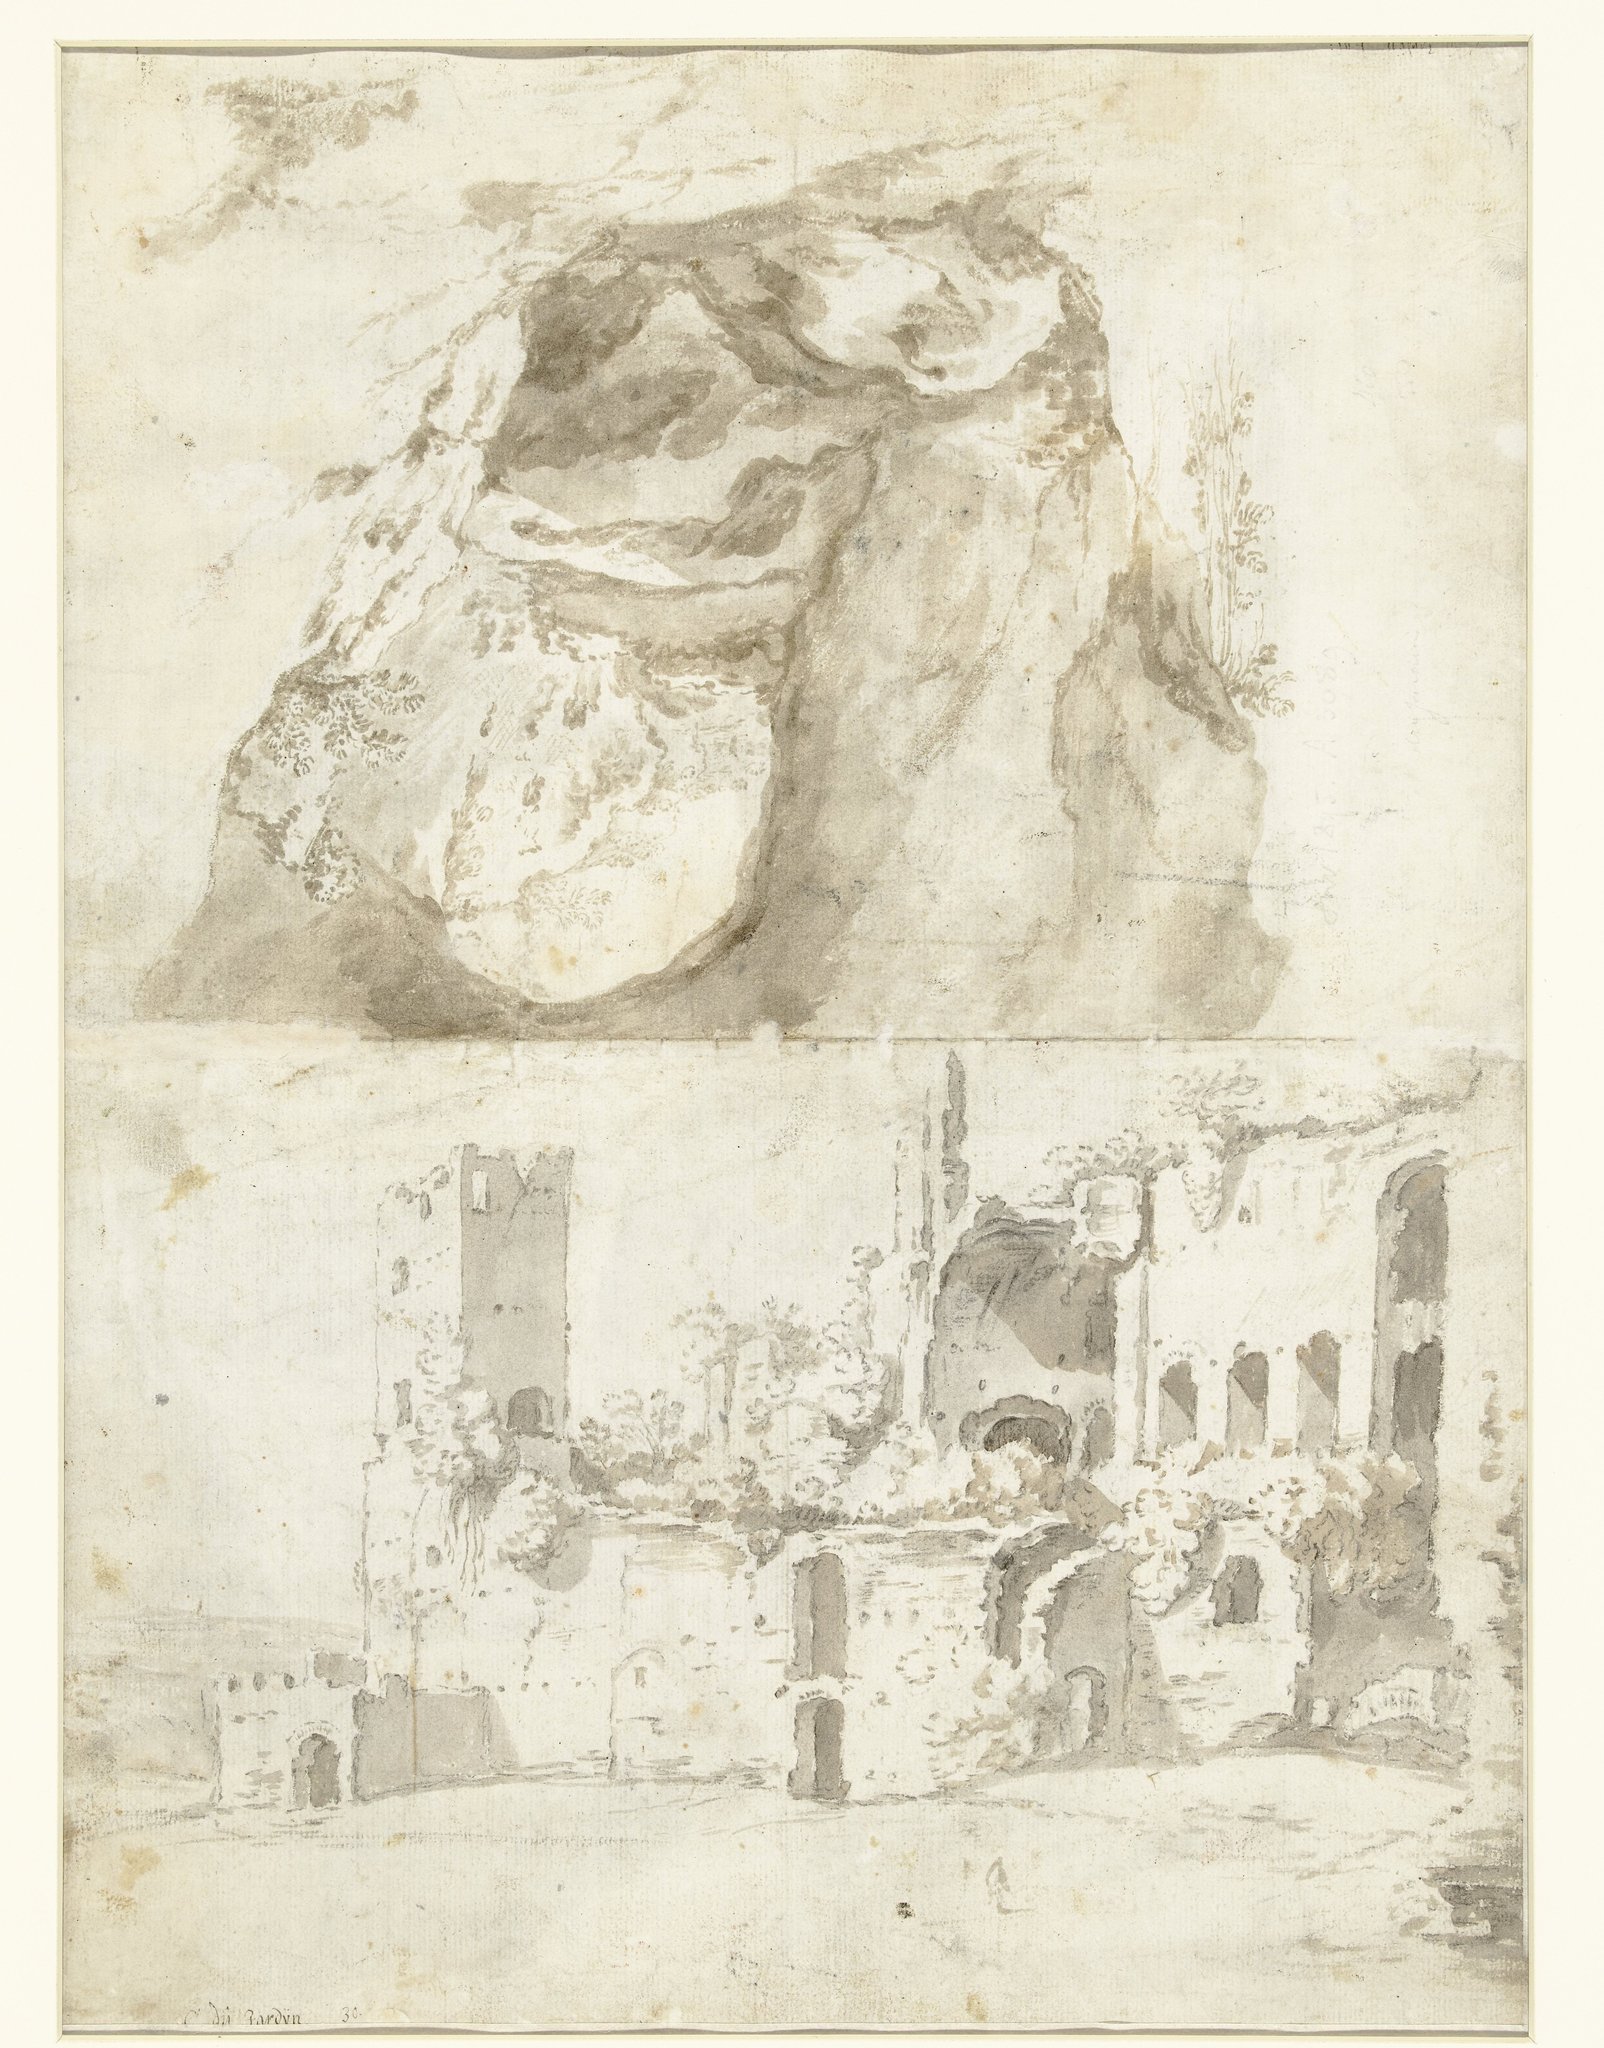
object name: drawing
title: View in a Cave and View of a Classical Ruin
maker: guilliam du gardijn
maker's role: draughtsman, painter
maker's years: 1595-1657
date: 1620-1625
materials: chalk, paper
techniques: brush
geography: rome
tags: ruin of a building ~ architecture, cave, grotto, italy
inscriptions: inscription: ‘G. du Jardijn. 30.’, inscription: ‘...du Jardijn.I. gl’